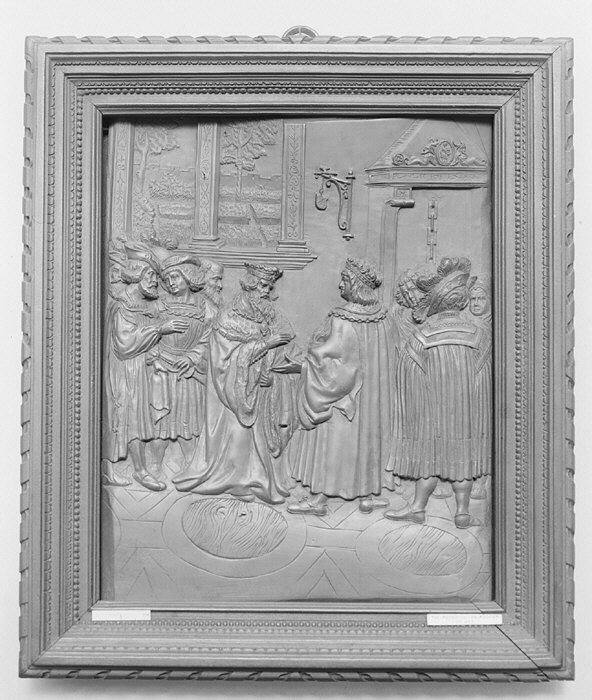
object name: plaque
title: Meeting of Maximilian and the Emperor Frederick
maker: hans burgkmair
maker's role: artist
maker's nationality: german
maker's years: 1473-1531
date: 1501-1600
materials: wood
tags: kings,men,trees